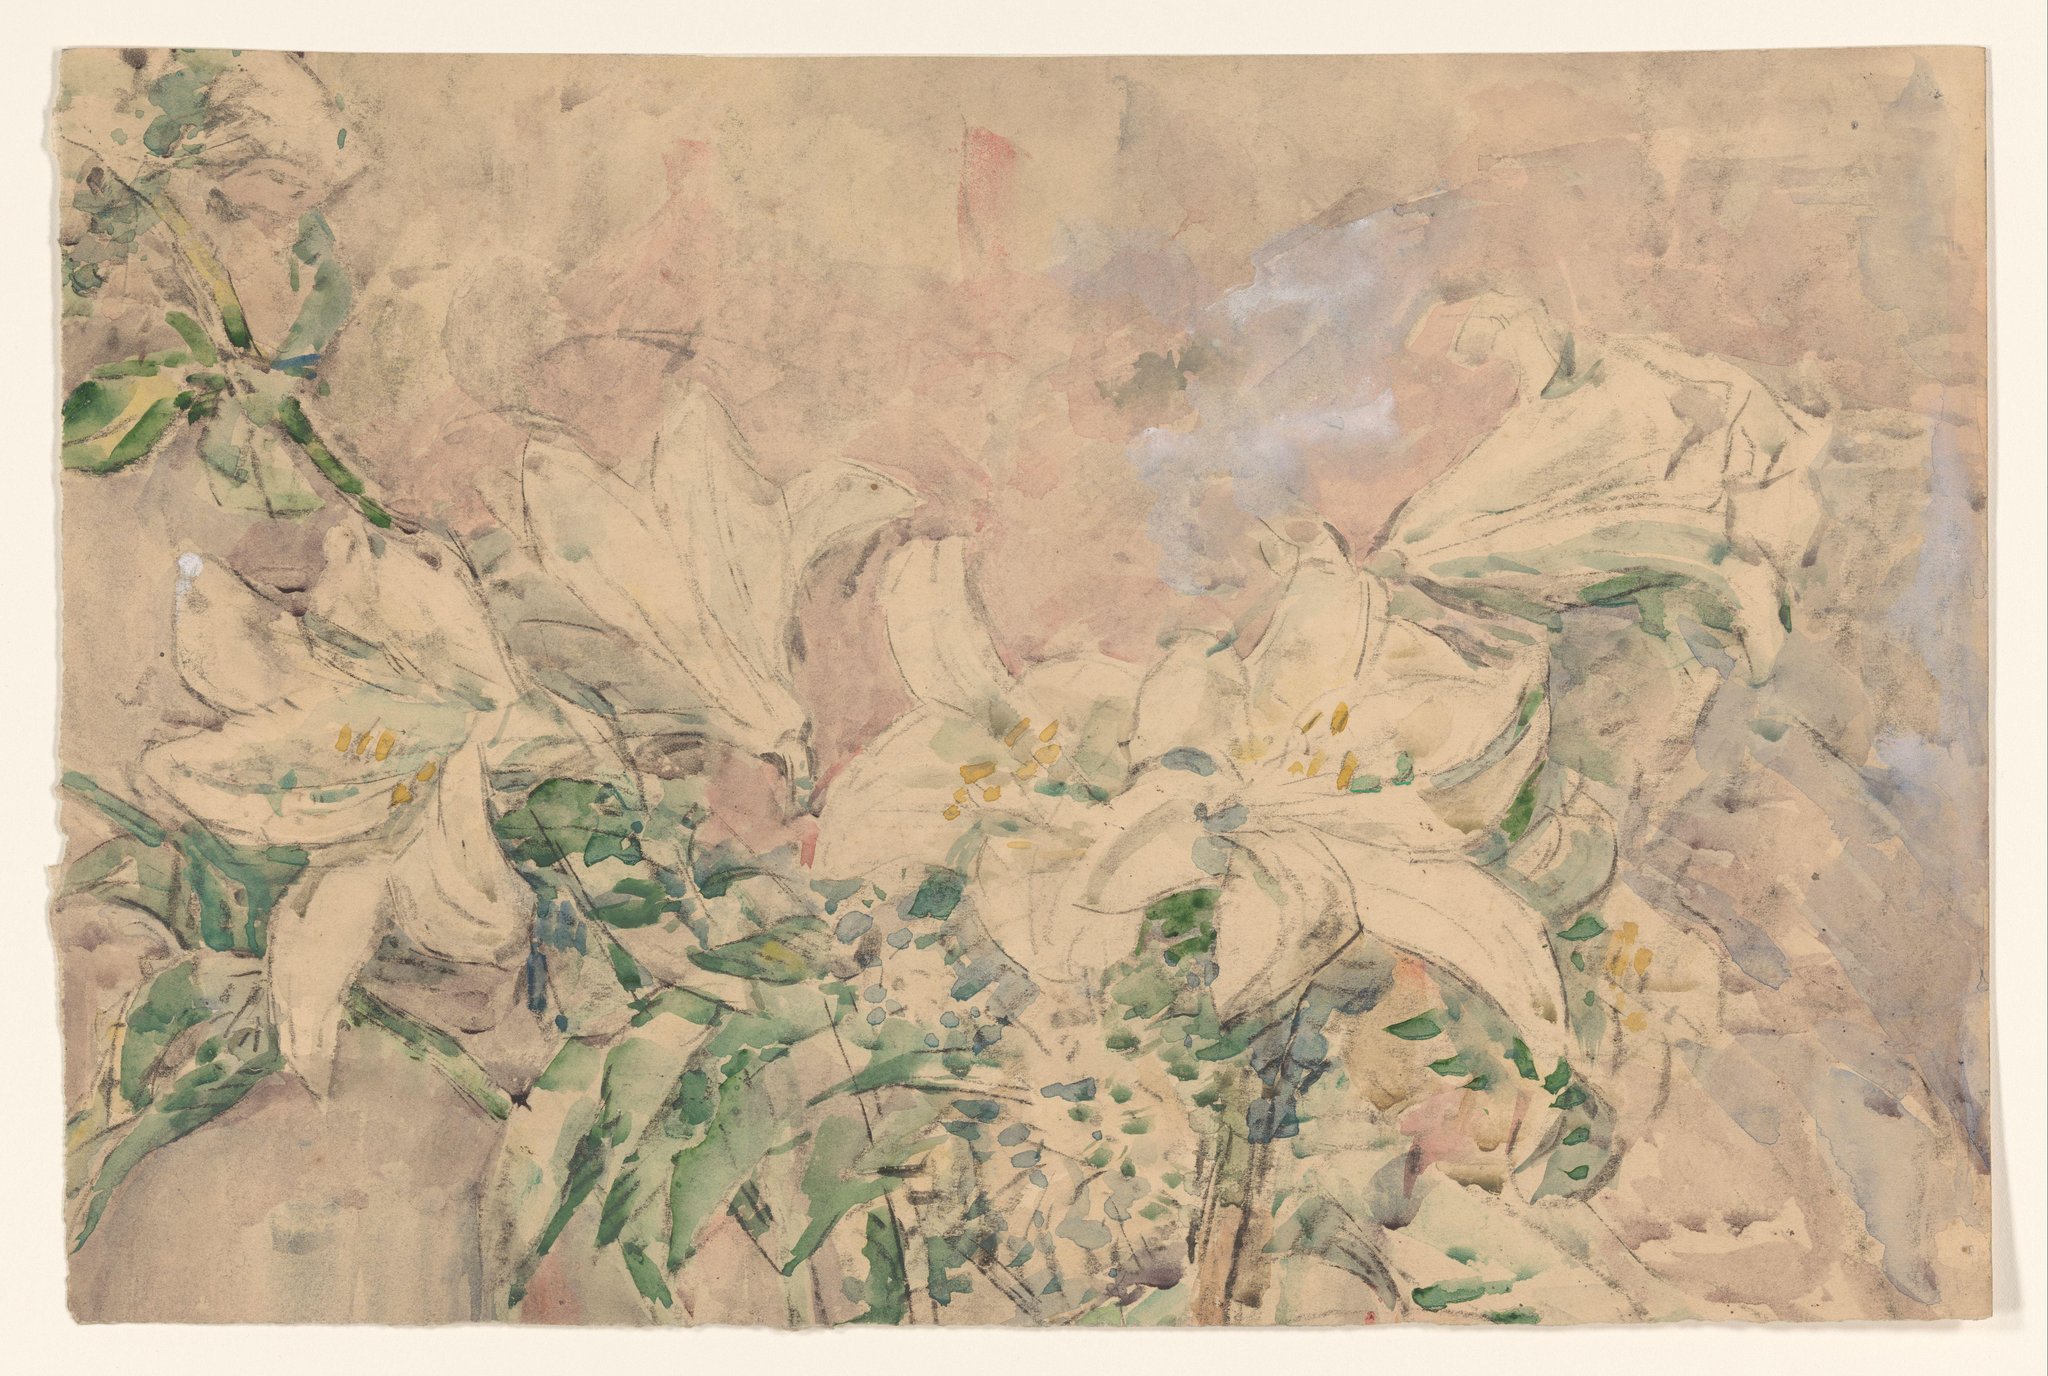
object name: drawing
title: Lelies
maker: wilhelmus johannes steenhoff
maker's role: draughtsman, print maker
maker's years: 1863-1932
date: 1873-1932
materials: chalk, paper, watercolor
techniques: brush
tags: flowers: lily, flowers in a vase